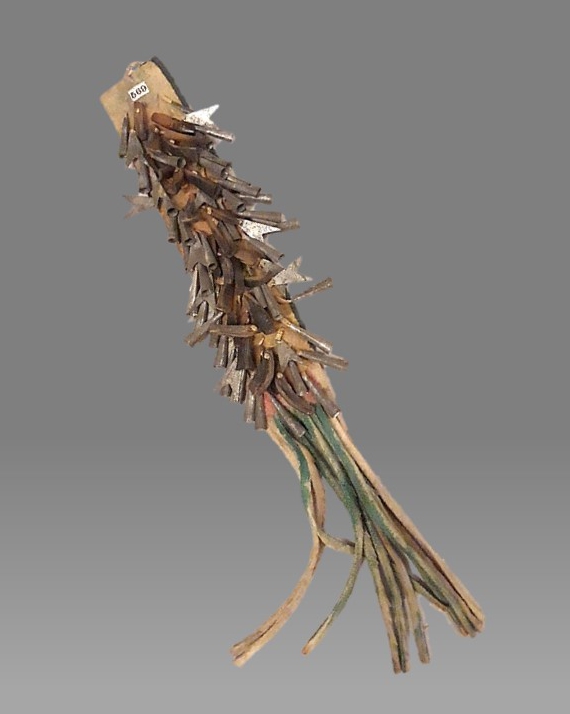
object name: napo kashke yu dha rattle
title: Napo-Kashke-Yu-Dha (rattle)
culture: native american, sioux or dakota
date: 1801-1900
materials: textile, tin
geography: united states